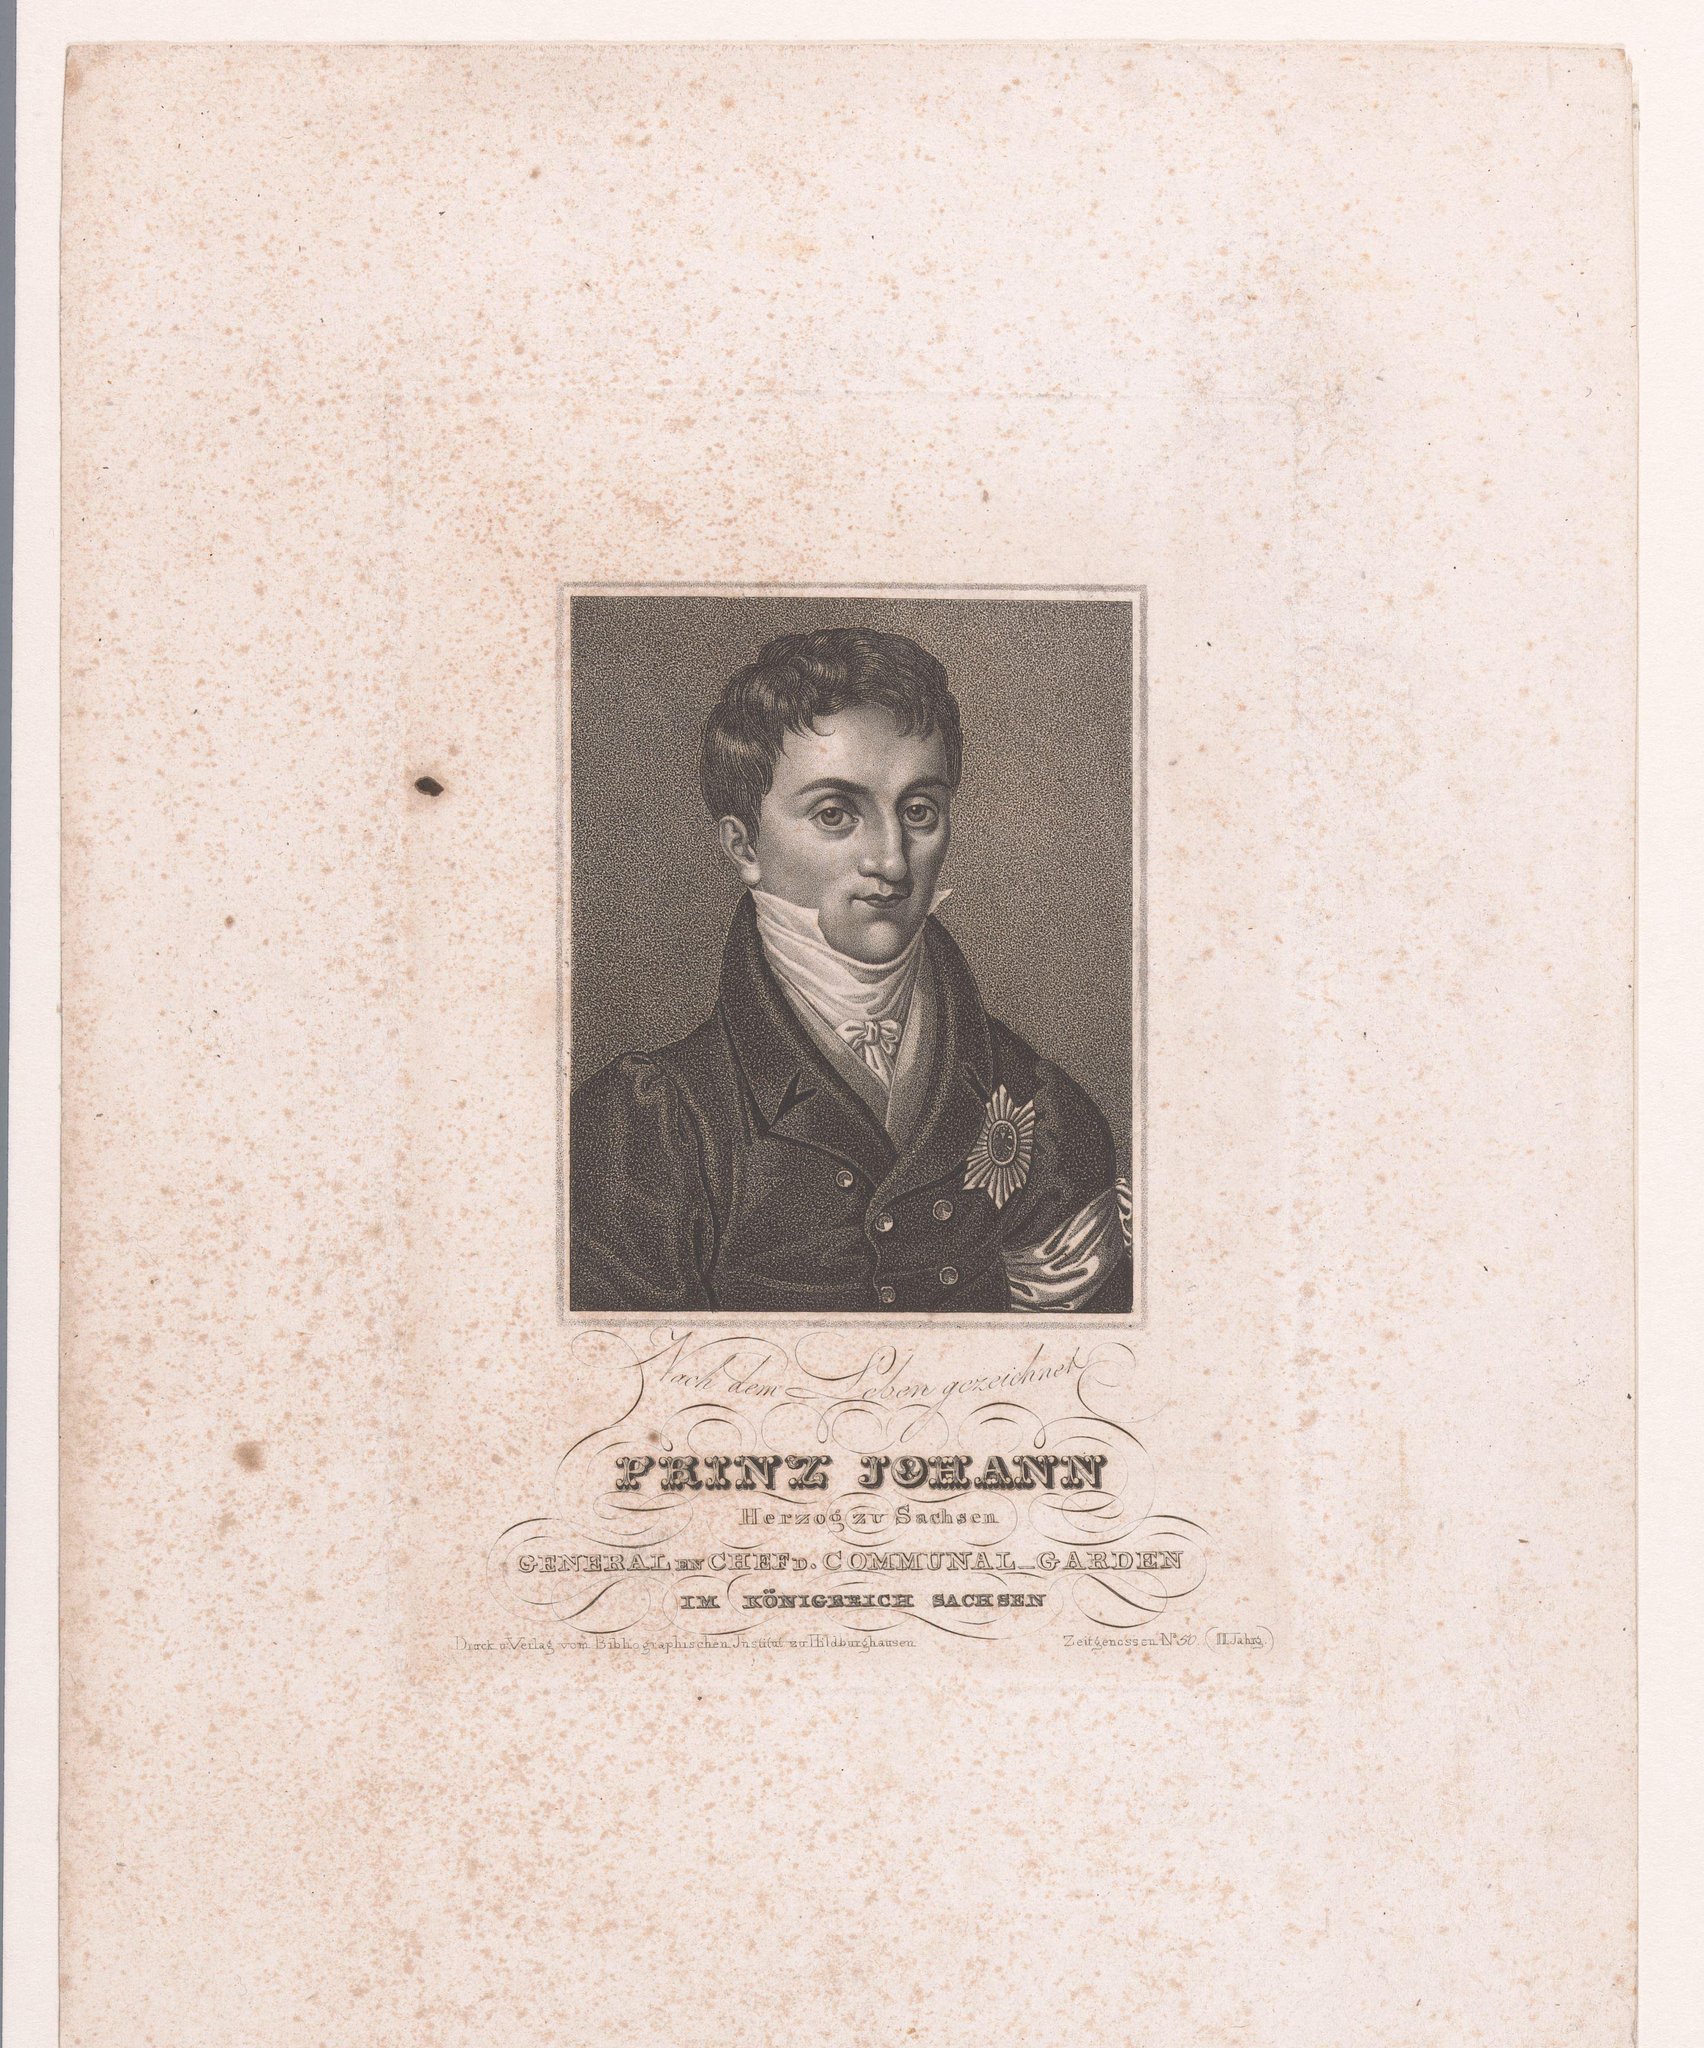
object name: print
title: Portret van Johann von Sachsen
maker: carl mayer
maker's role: print maker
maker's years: 1798-1868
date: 1829-1840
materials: paper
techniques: stippling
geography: hildburghausen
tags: historical persons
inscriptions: collector's mark: Lugt 2228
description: Afkomstig uit de portretserie 'Zeitgenossen', uitgegeven tussen 1829 en circa 1840.